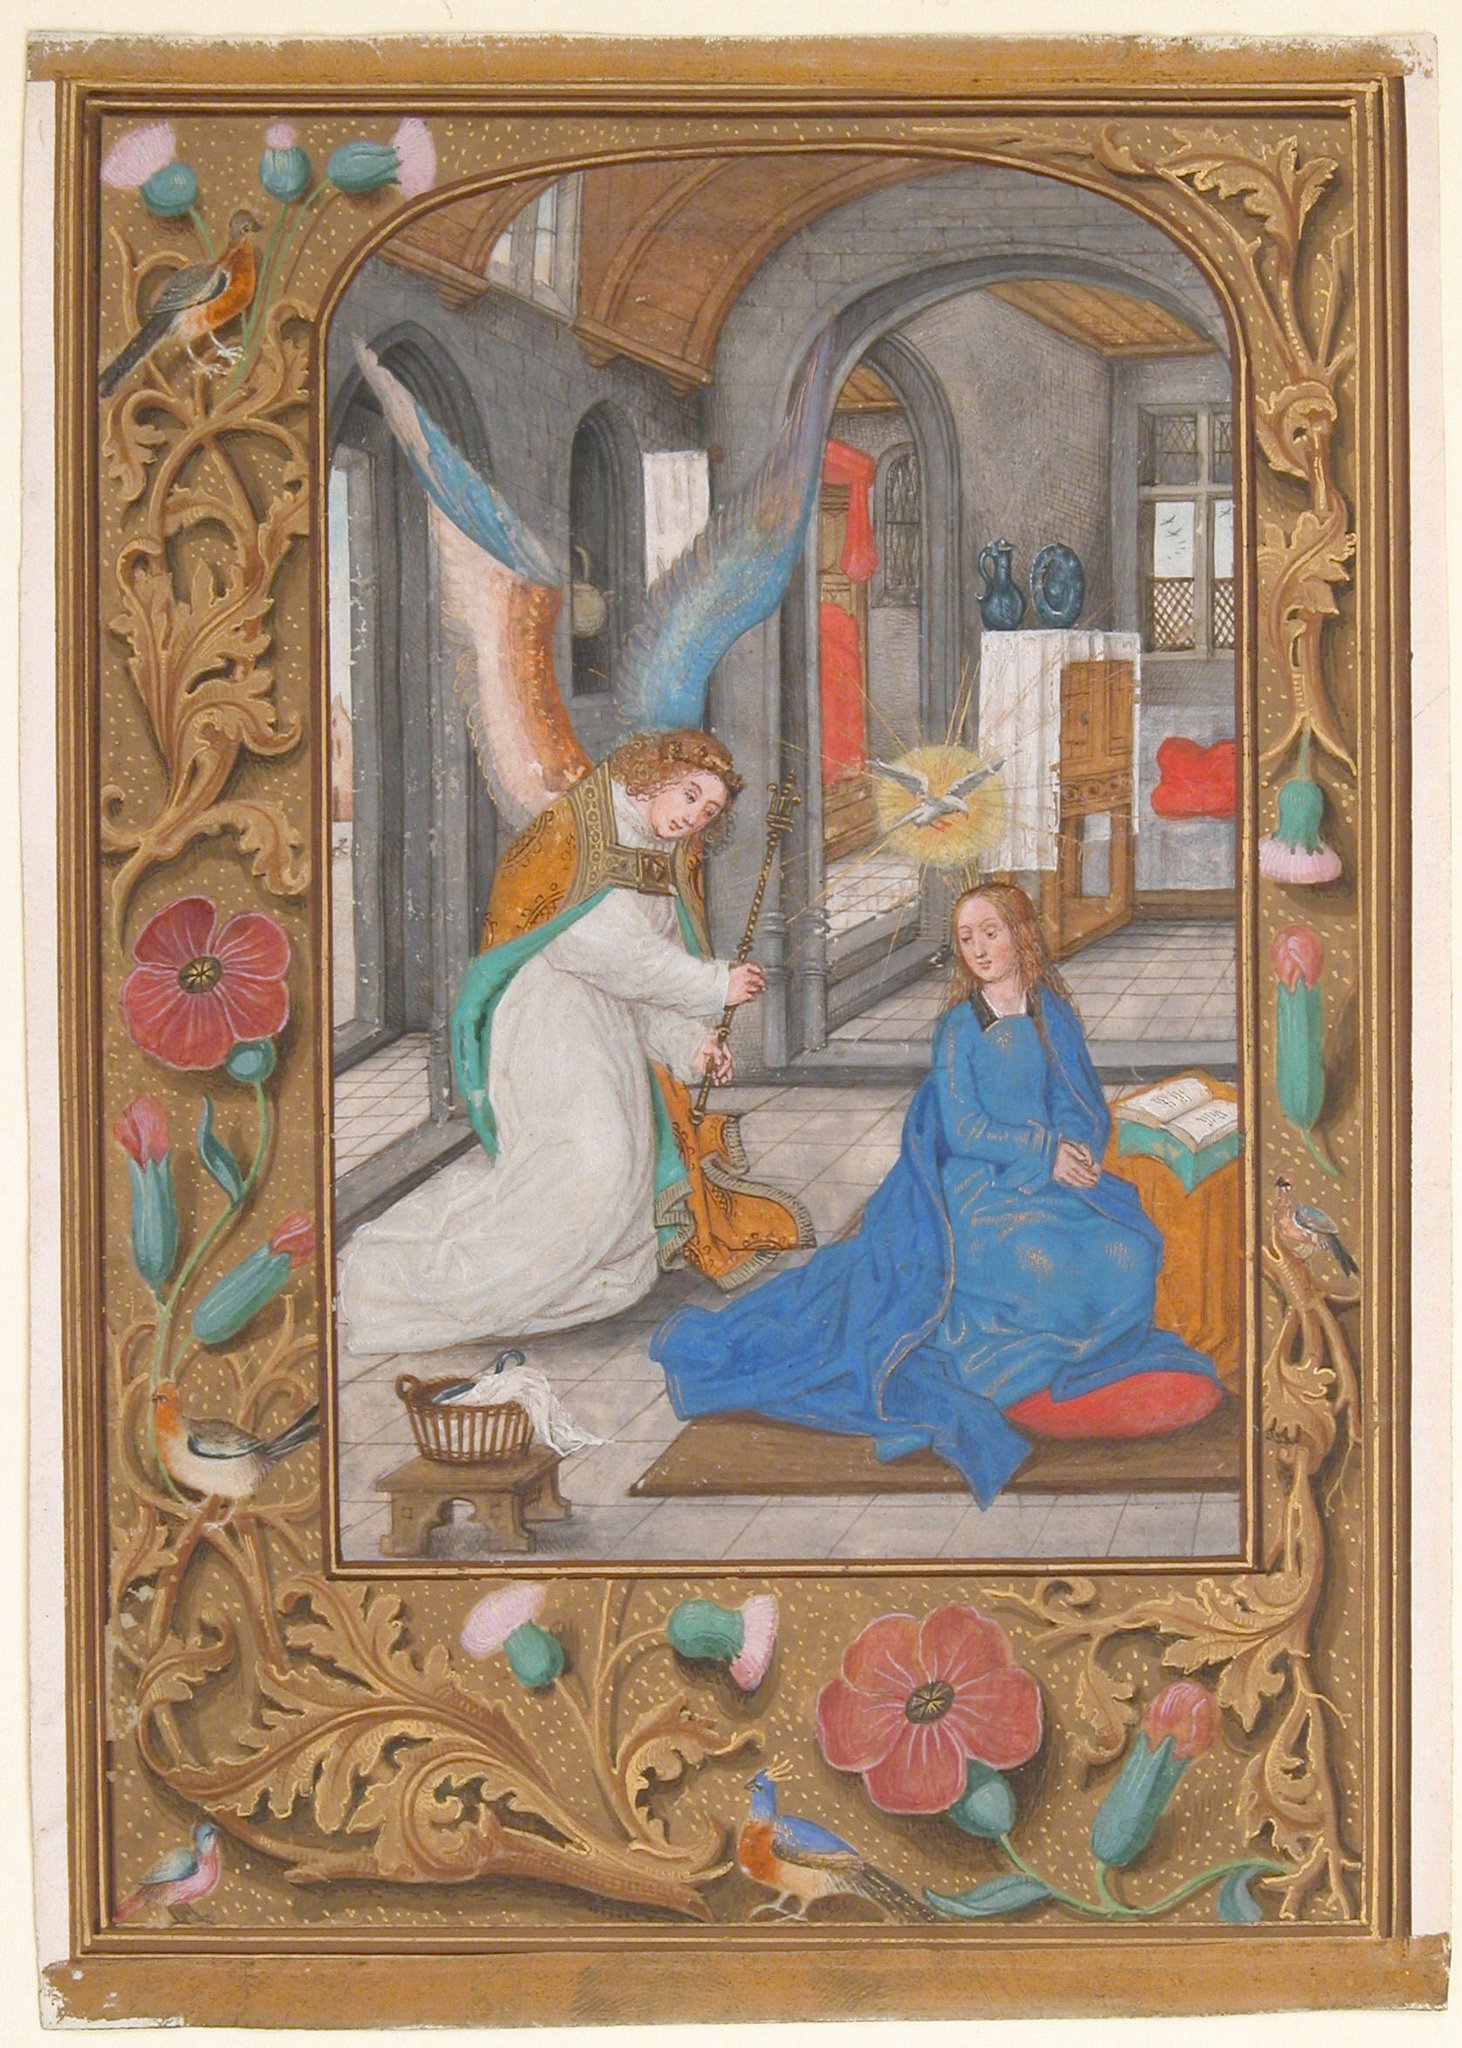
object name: book of hour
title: Manuscript Leaf with the Annunciation, from a Book of Hours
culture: dutch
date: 1500-1525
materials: gold, ink, parchment, shell, paint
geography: netherlands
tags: angels,virgin mary